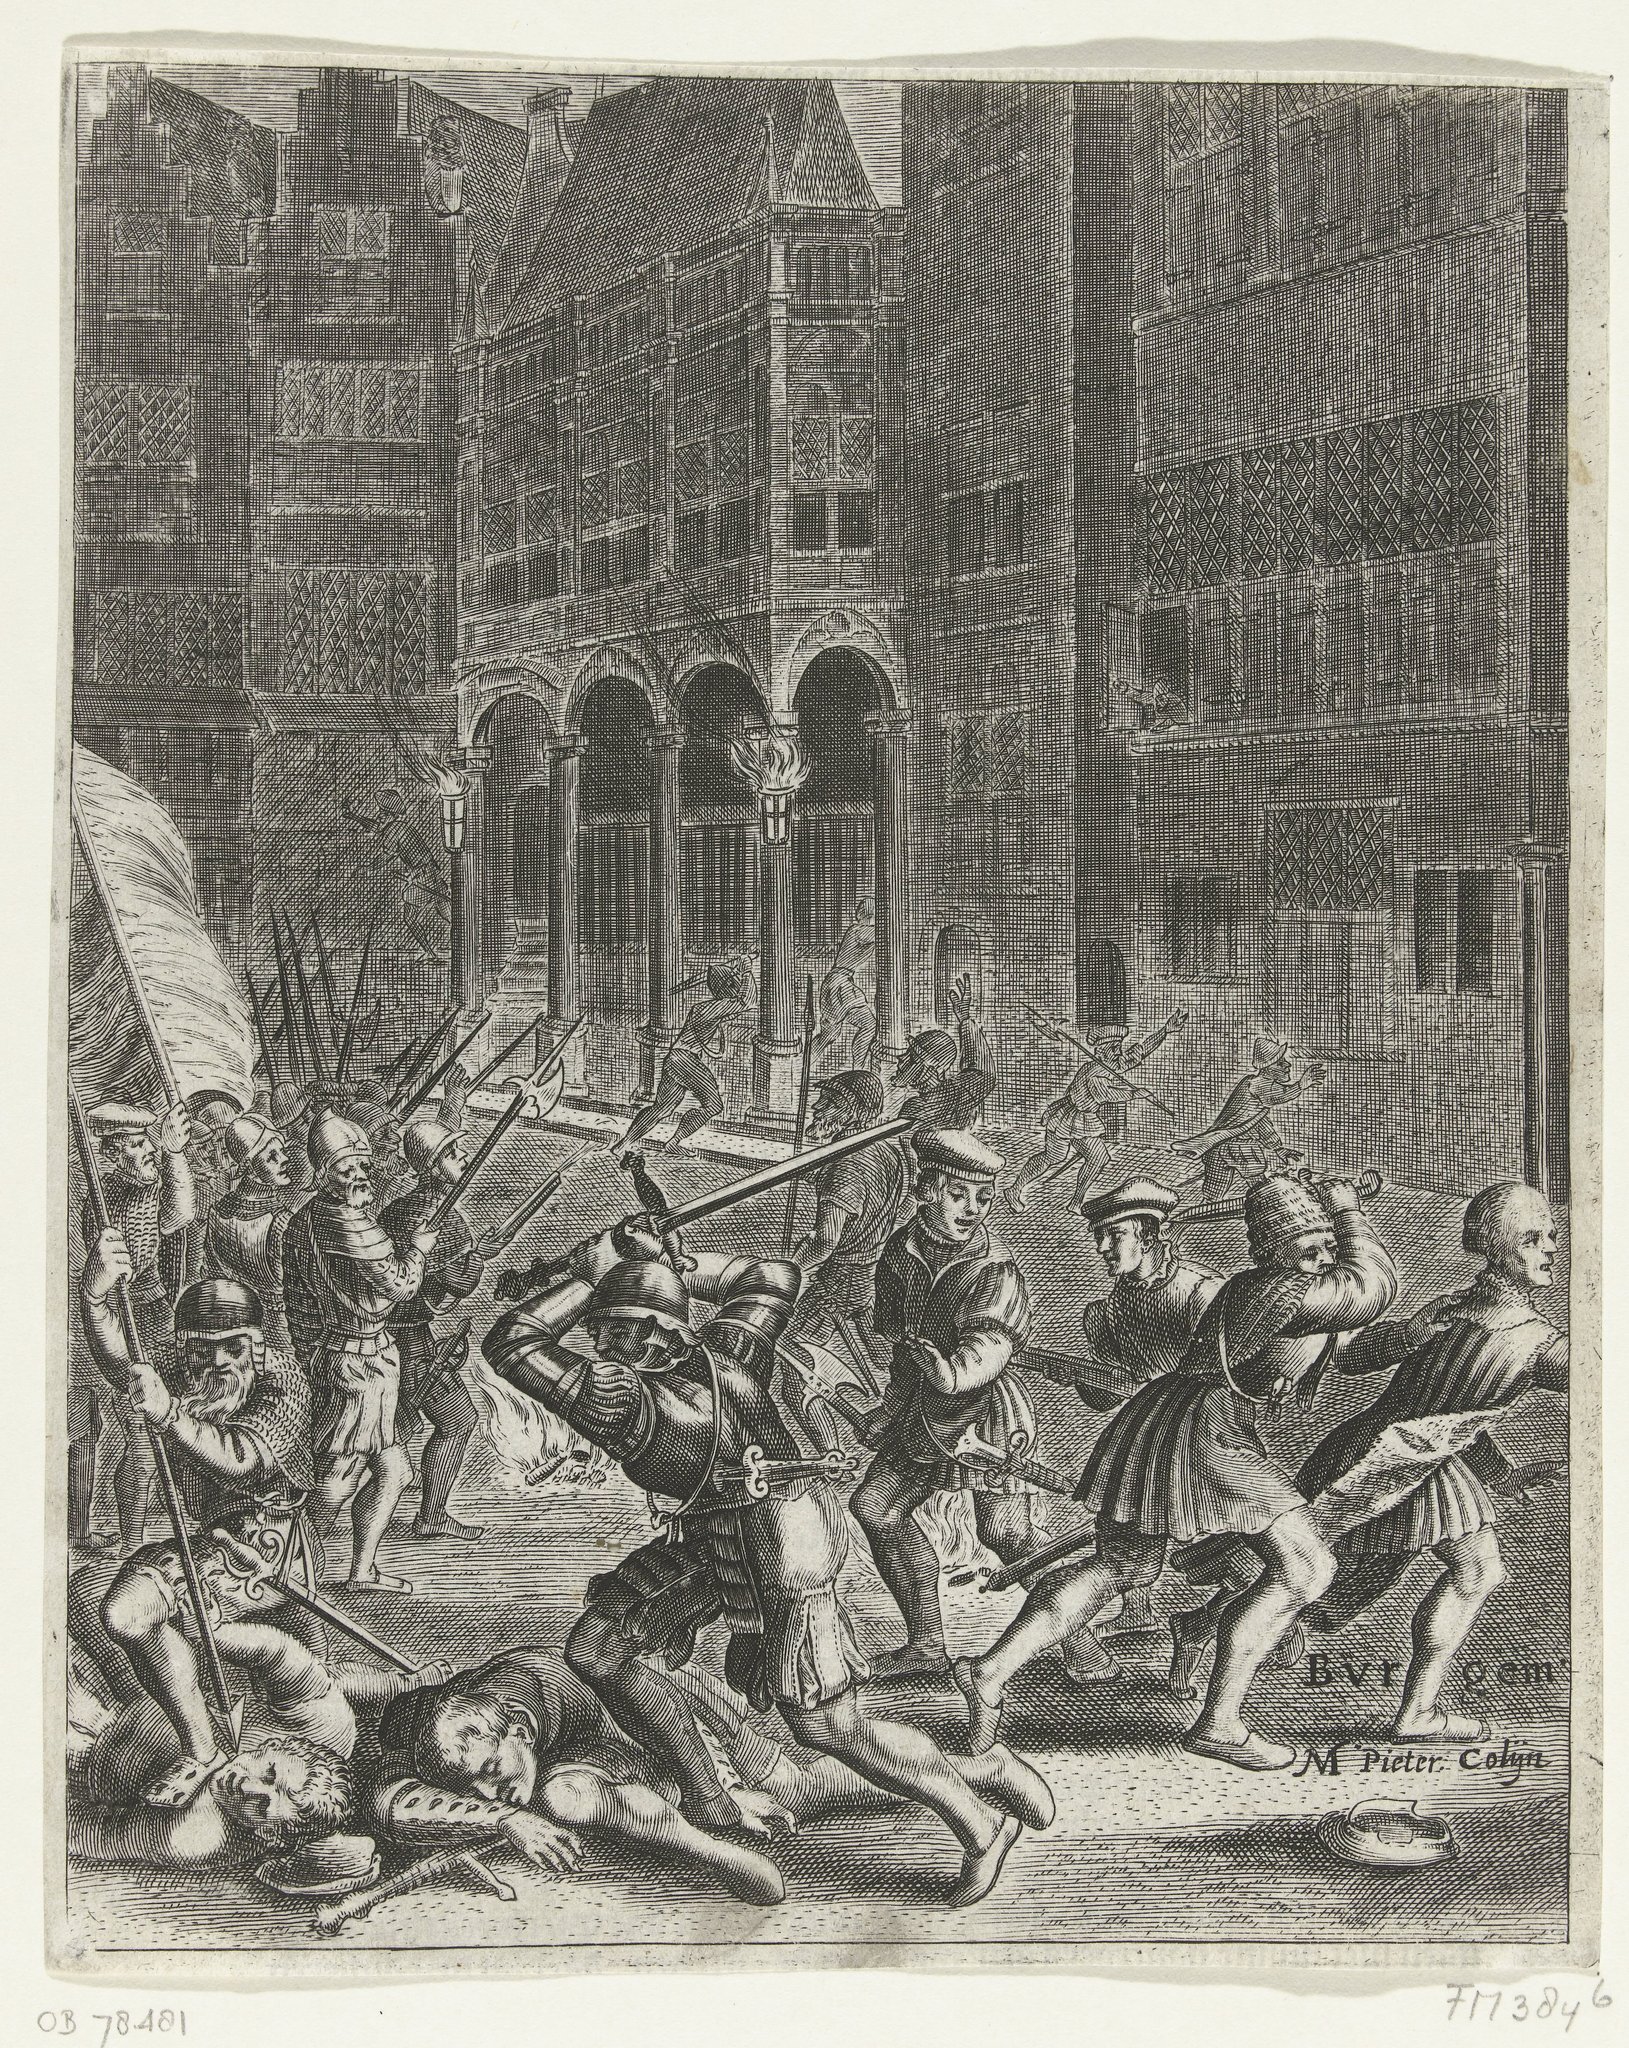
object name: history print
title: De wederdopers bezetten de Dam, 1535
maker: Anonymous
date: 1612-1614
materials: paper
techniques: engraving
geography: northern netherlands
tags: violent death, being killed; being mishandled and maltreated; seeking death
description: Illustratie voor: L. Hortensius, Het boeck D. Lamberti Hortensii (...). Van den oproer der weder-dooperen, J. L. Meyn, Enkhuizen 1614, p. 20. Naar het verloren gegane schilderij van Barend Dircksz. in het oude stadhuis te Amsterdam.